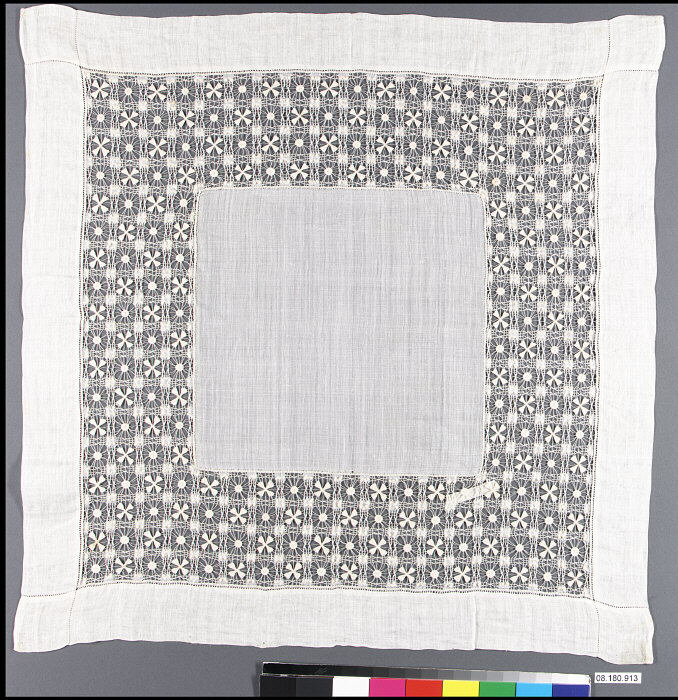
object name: handkerchief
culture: mexican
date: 1801-1900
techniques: lace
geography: mexico